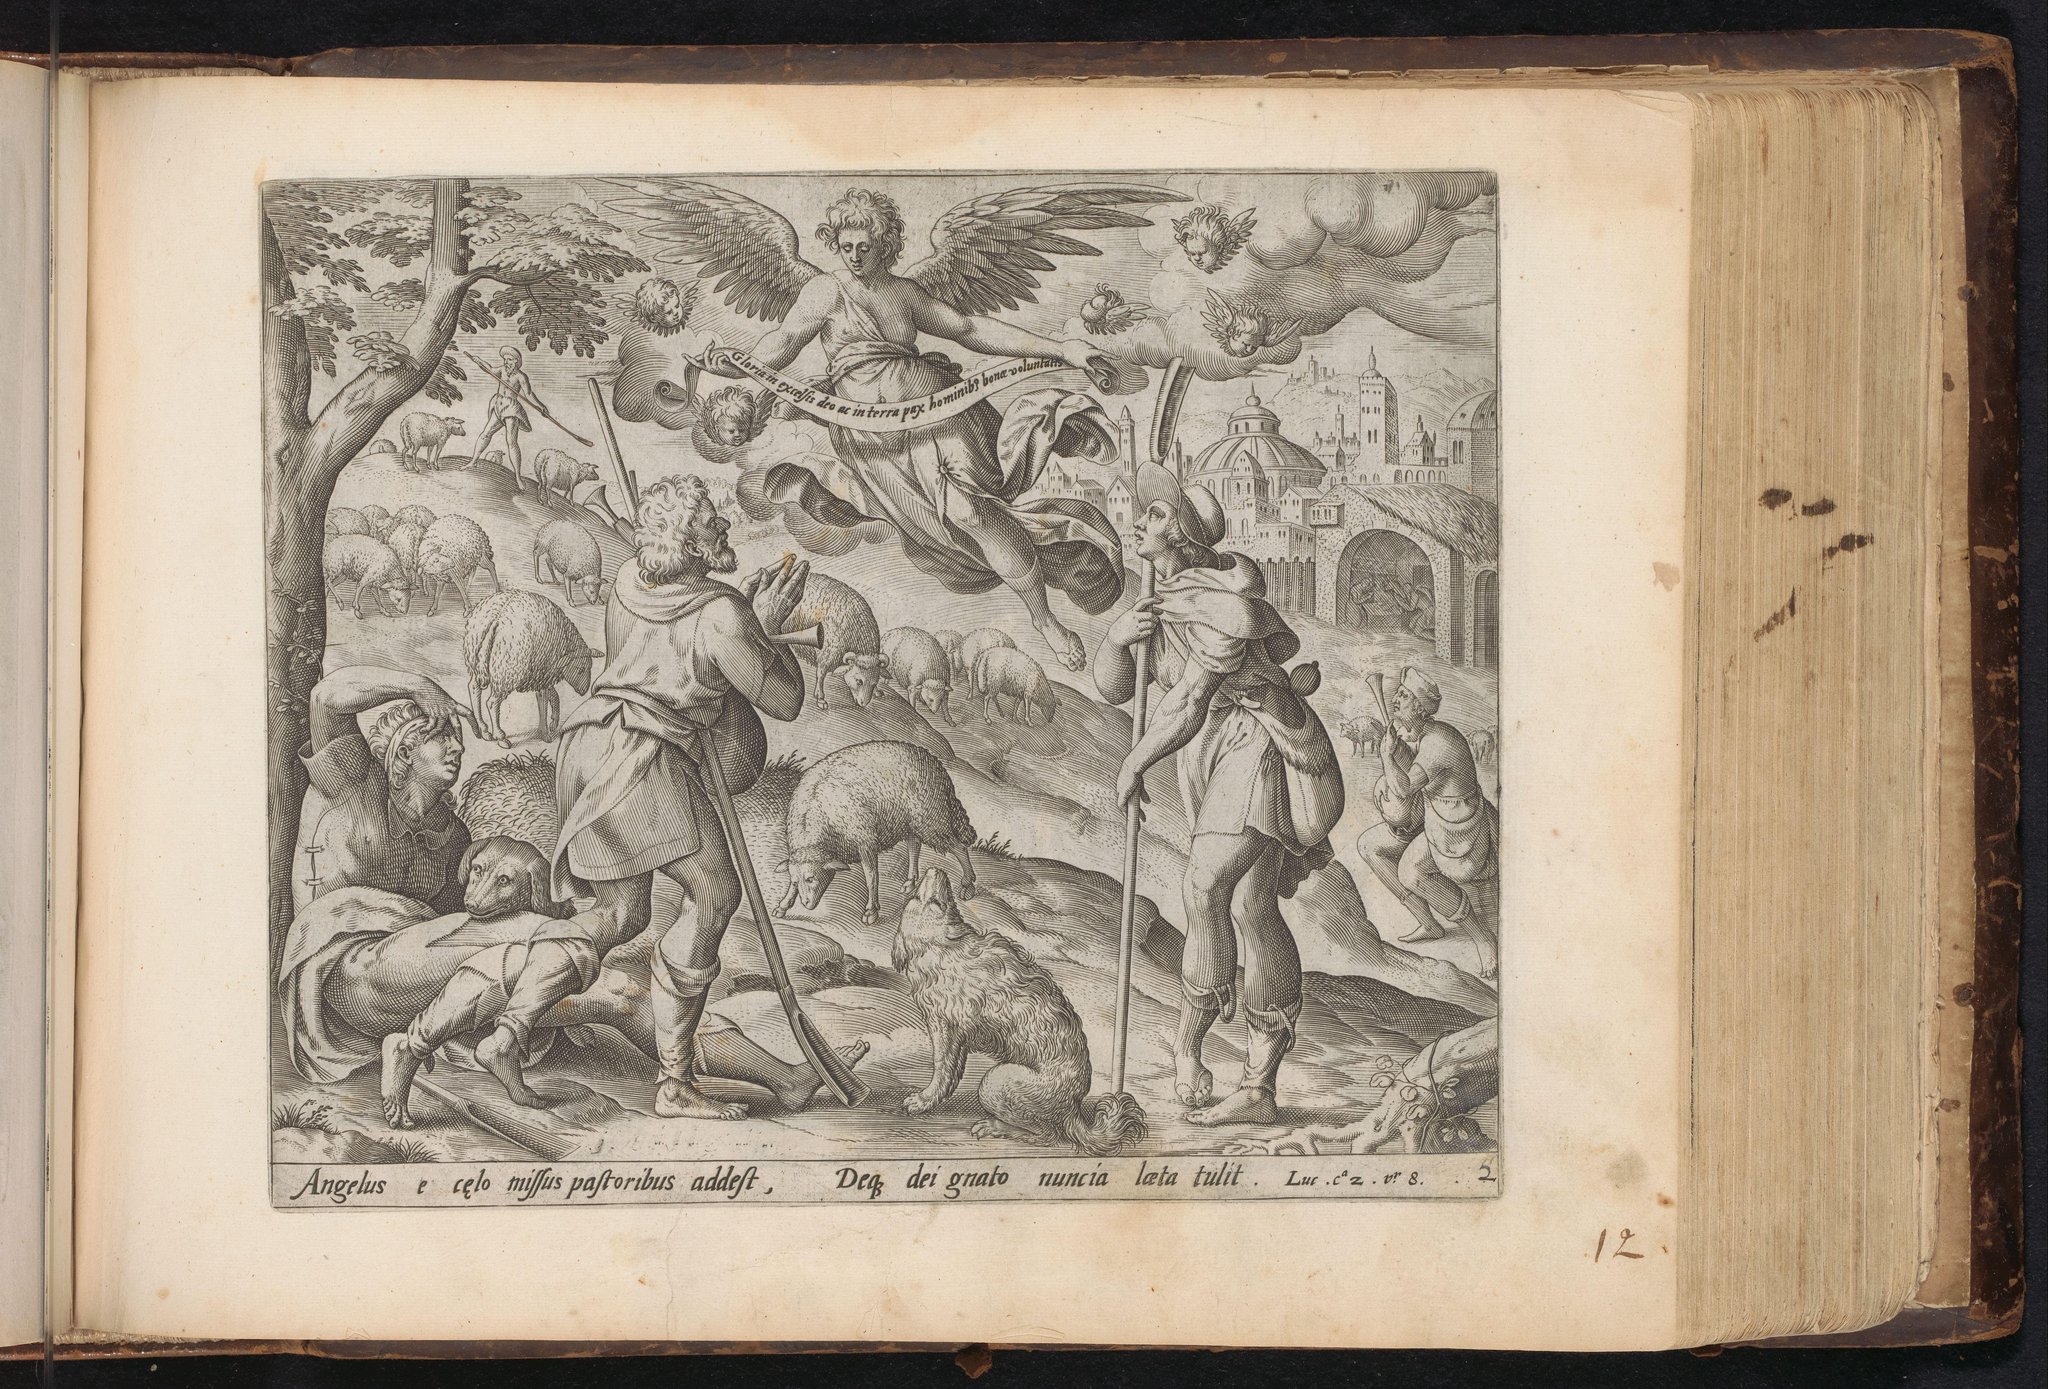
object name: print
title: Verkondiging aan de herders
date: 1572-1576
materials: paper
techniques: engraving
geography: alkmaar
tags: annunciation of christ's birth to the shepherds (and/or shepherdesses) at night; a host of singing angels in the air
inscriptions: serial number: ‘2’, number: ‘12’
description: Een engel verkondigt de geboorte van Christus aan de herders, die met hun schapen op het veld zijn. Rechts op de achtergrond de stal met Maria en Jozef bij de kribbe. Onder de voorstelling een verwijzing in het Latijn naar de Bijbeltekst in Luc. 2:8. Deze prent maakt deel uit van een album.